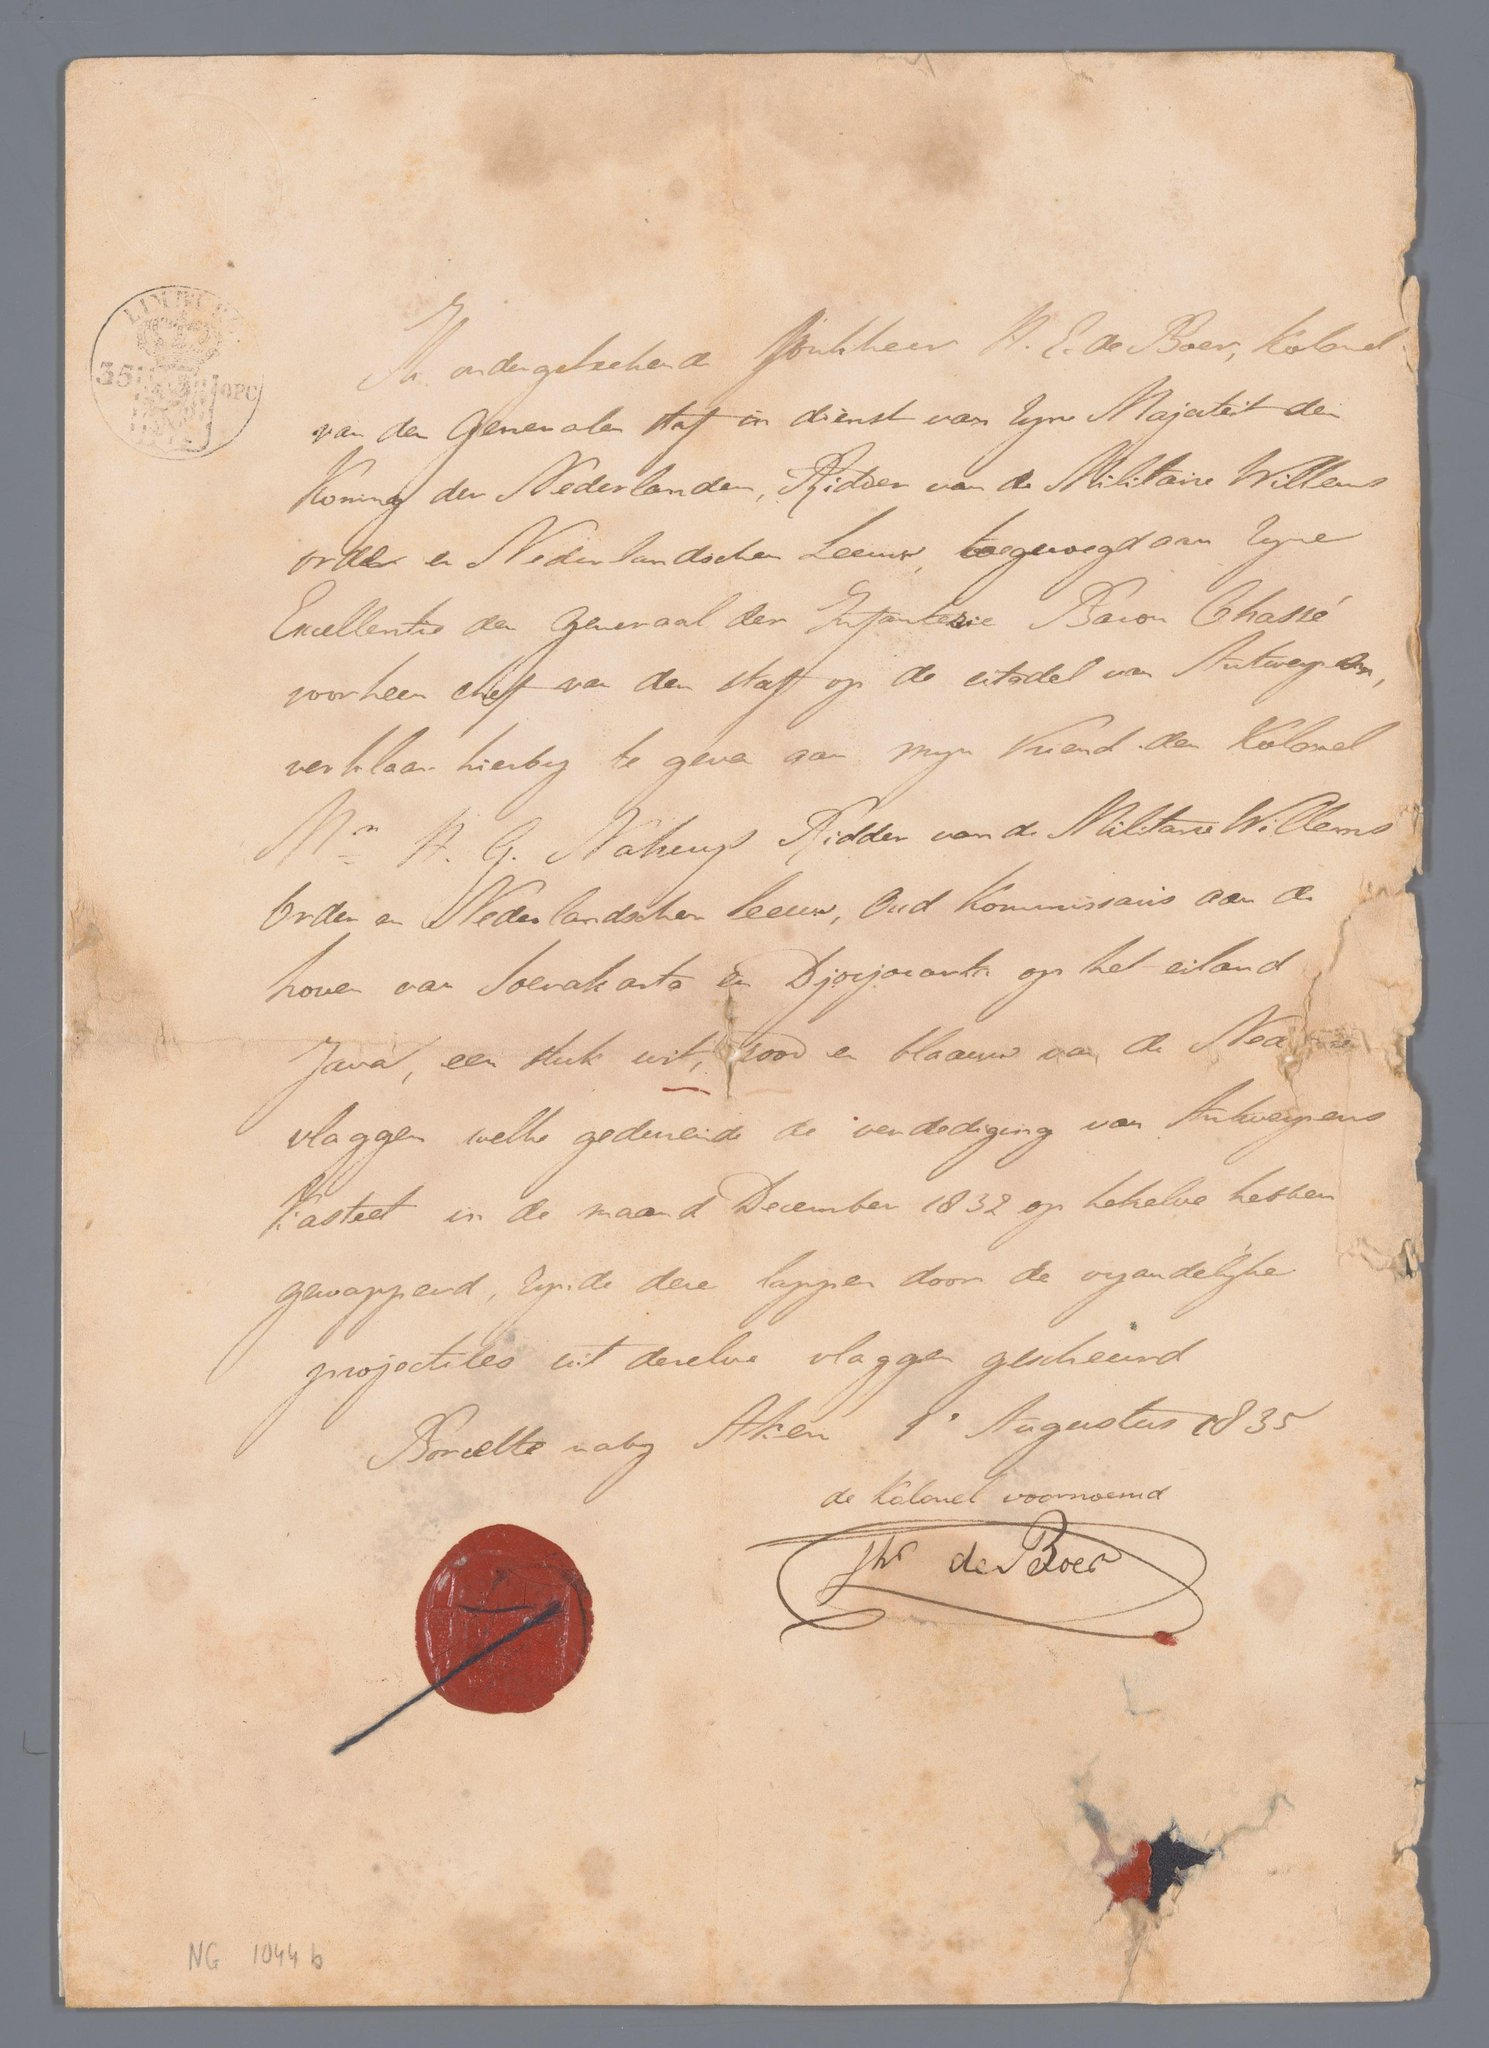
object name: bewijs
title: Document van echtheid van de Nederlandse vlag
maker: jonkheer h. e. de boer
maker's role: kolonel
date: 1835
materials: ink, paper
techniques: writing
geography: aachen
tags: antwerp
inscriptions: date